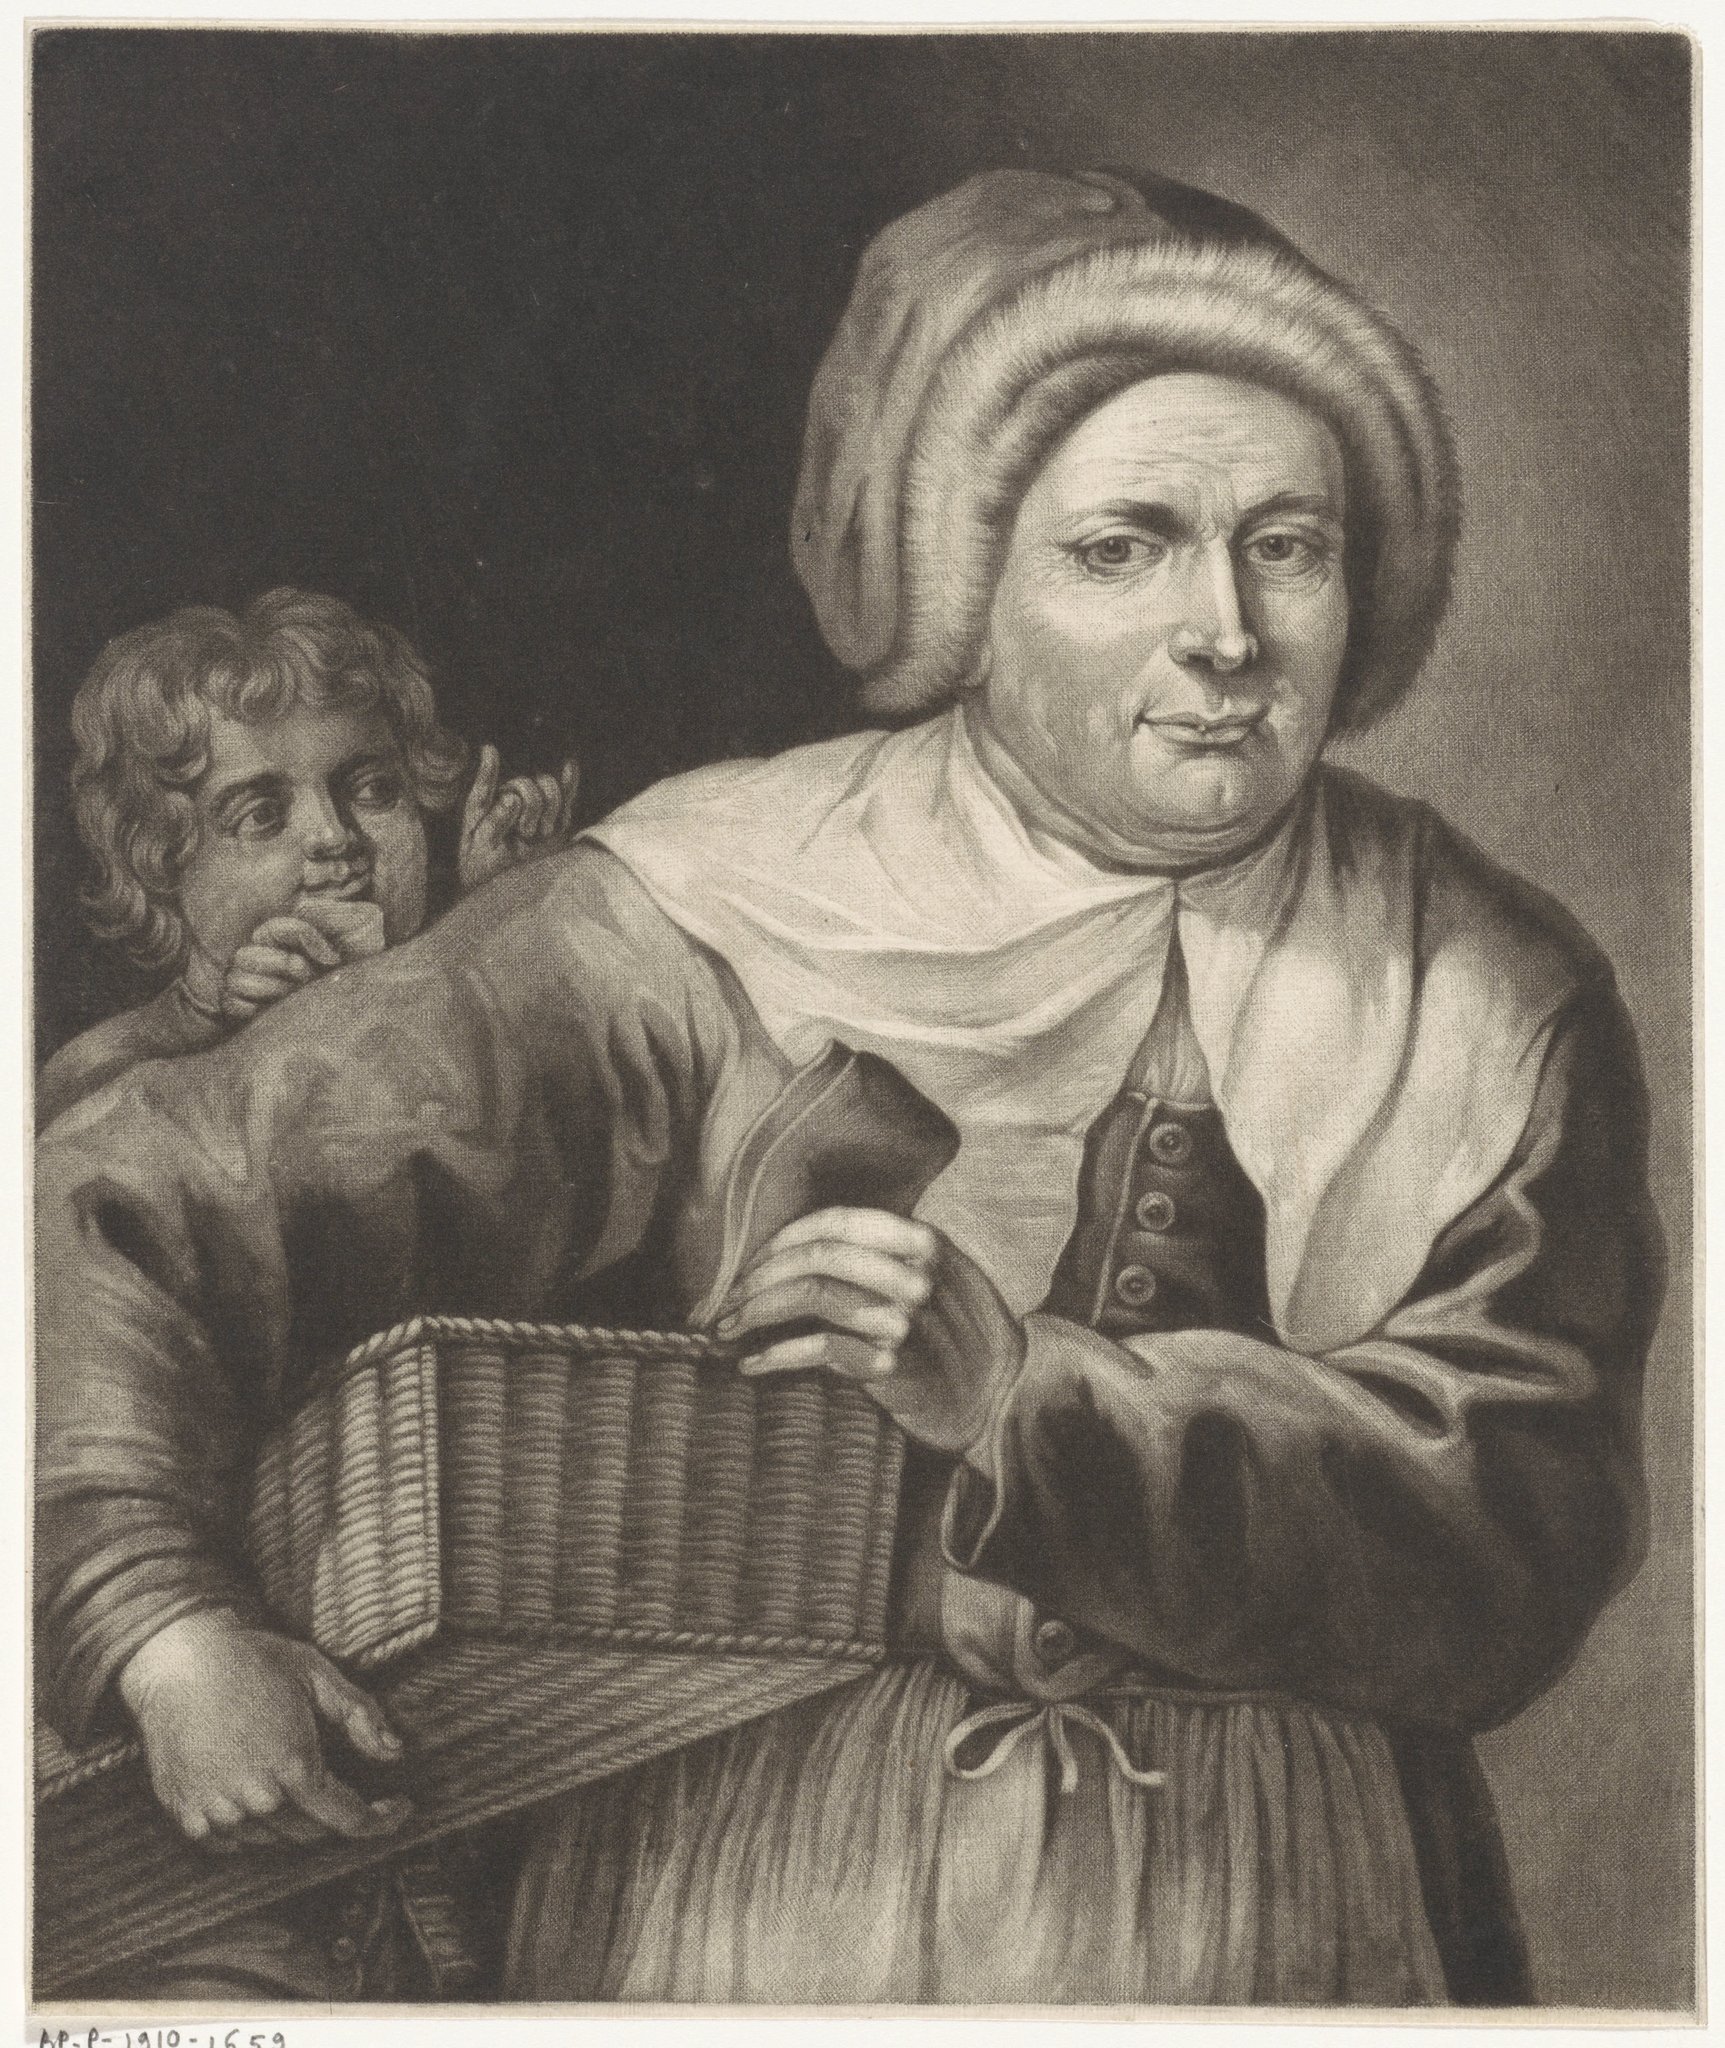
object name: print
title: Vrouw met een mand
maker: Anonymous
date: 1650-1800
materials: paper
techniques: mezzotint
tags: carrying something in basket, bag, rucksack, etc.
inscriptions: collector's mark: Lugt 2228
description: Een vrouw met een bontmunts draagt een mand. Achter haar staat een jongen die het 'corna' (hoorntje) gebaar maakt met zijn vingers.